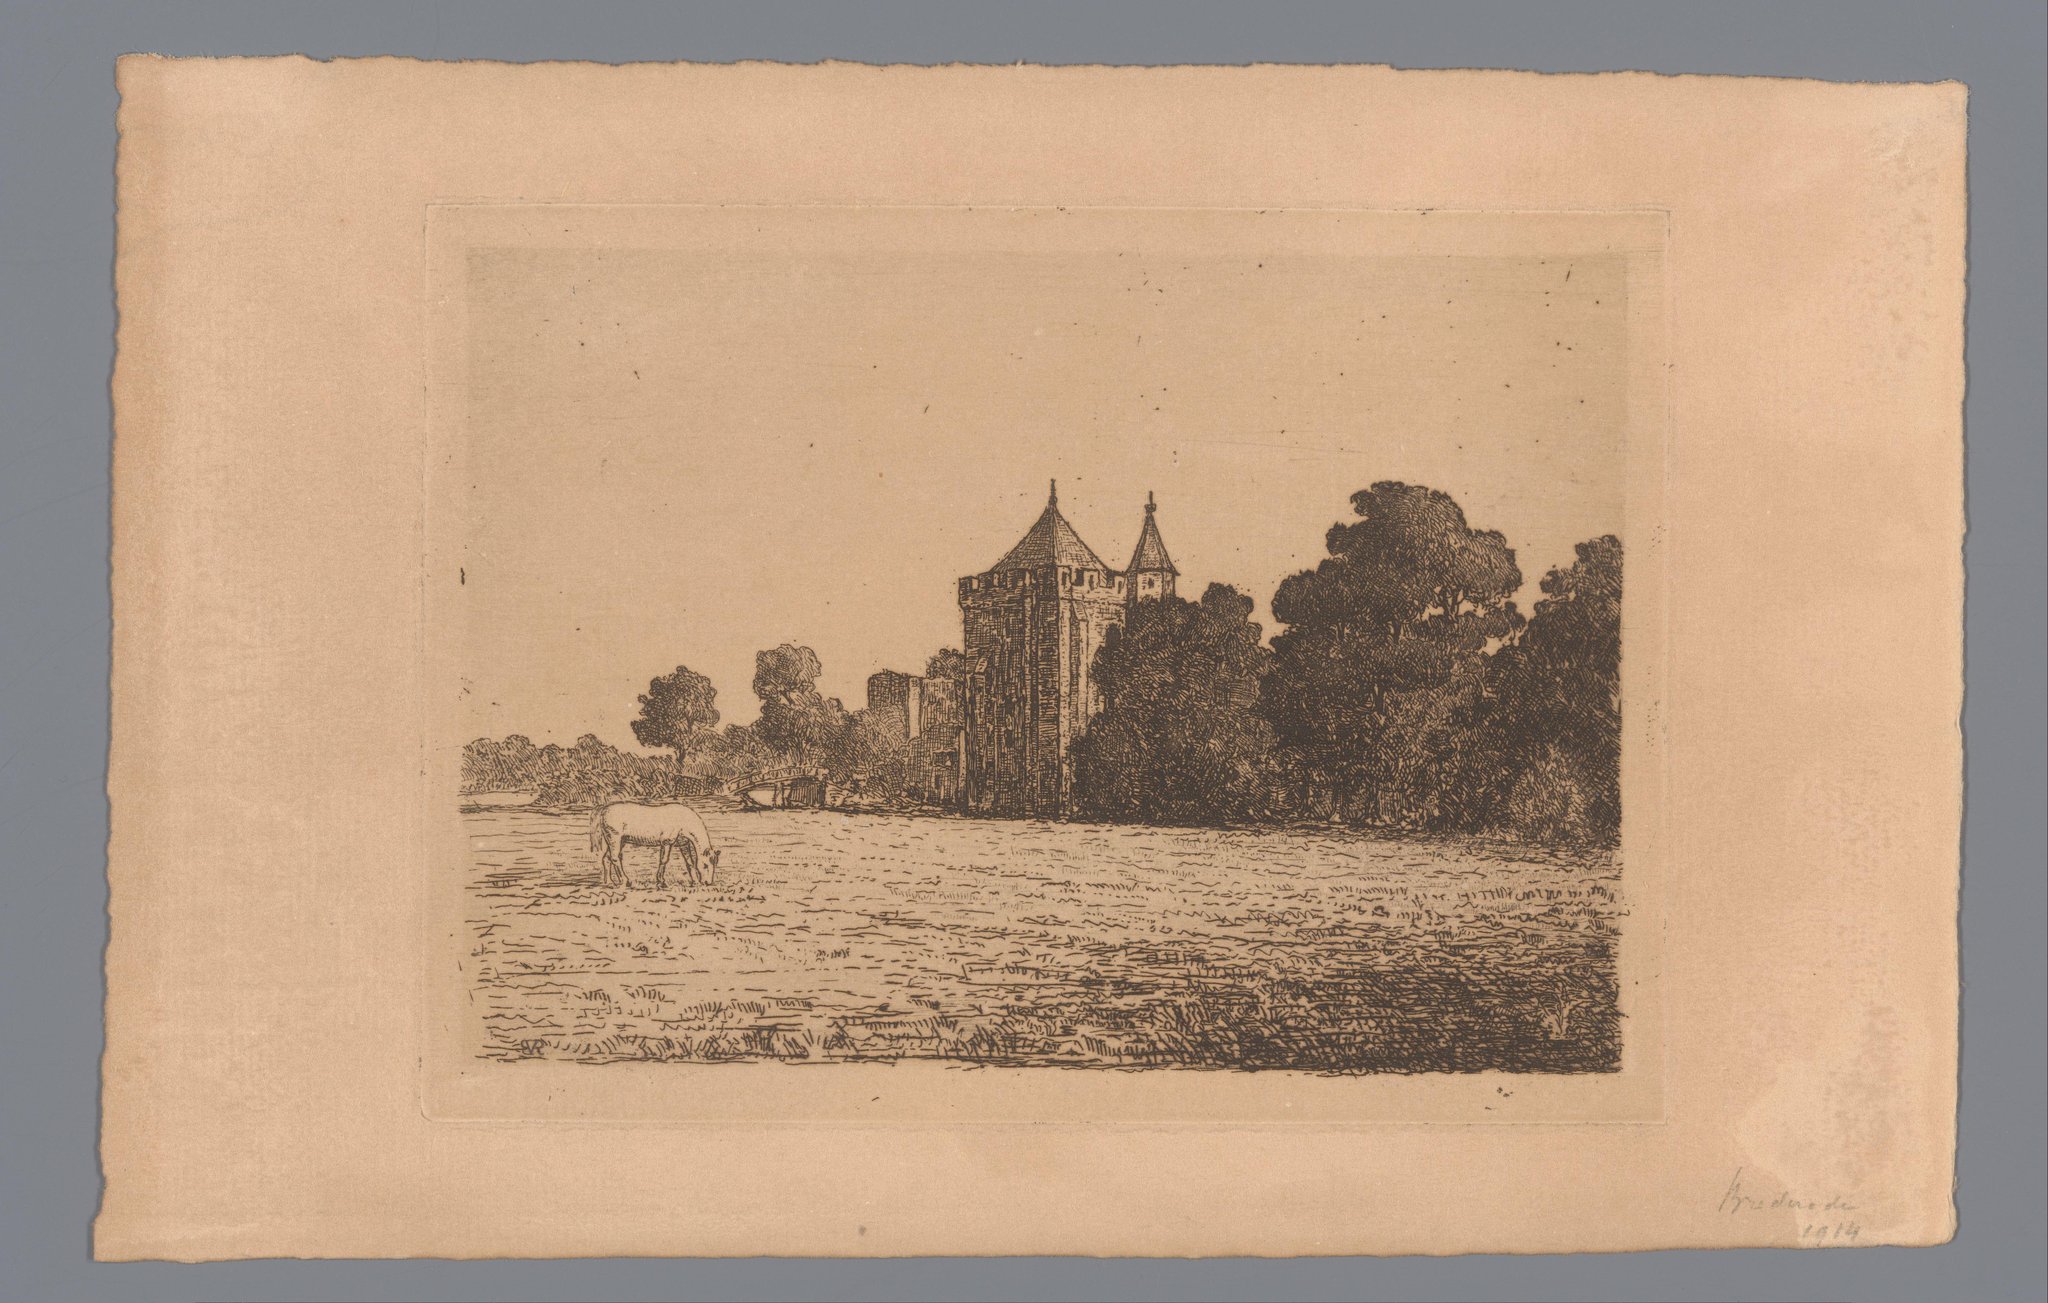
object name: print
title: Gezicht op Kasteel Brederode vanaf een weiland gezien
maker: jonkheer barthold willem floris van riemsdijk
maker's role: engineer, print maker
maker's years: 1850-1942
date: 1865-1918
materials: paper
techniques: etching, intaglio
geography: netherlands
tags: castle, horse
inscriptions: collector's mark: Lugt 2233